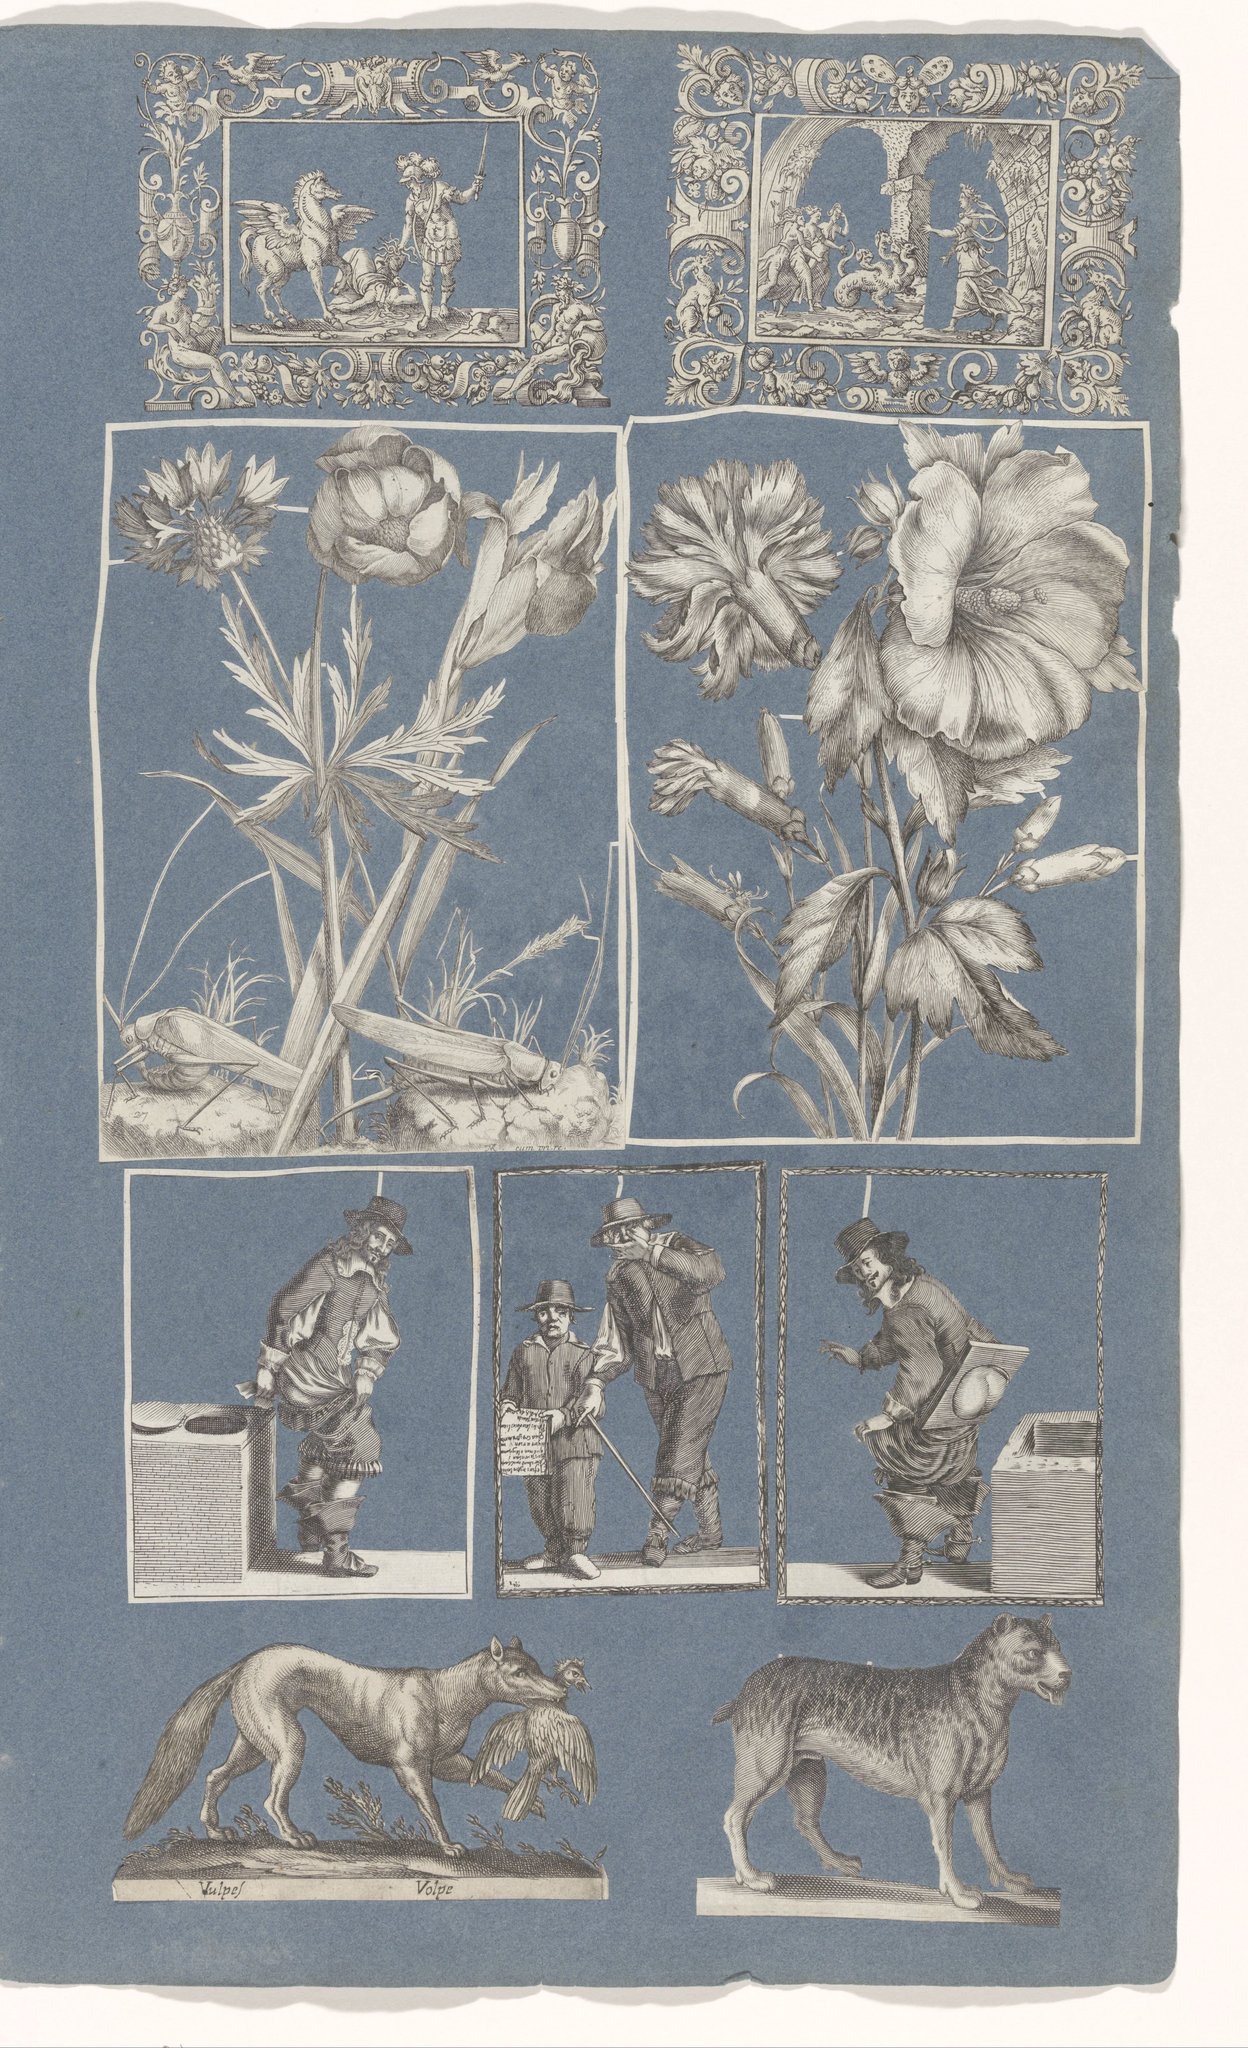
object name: print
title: Collage van uitgeknipte prenten geplakt op albumblad van blauw papier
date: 1585-1700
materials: paper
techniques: collage